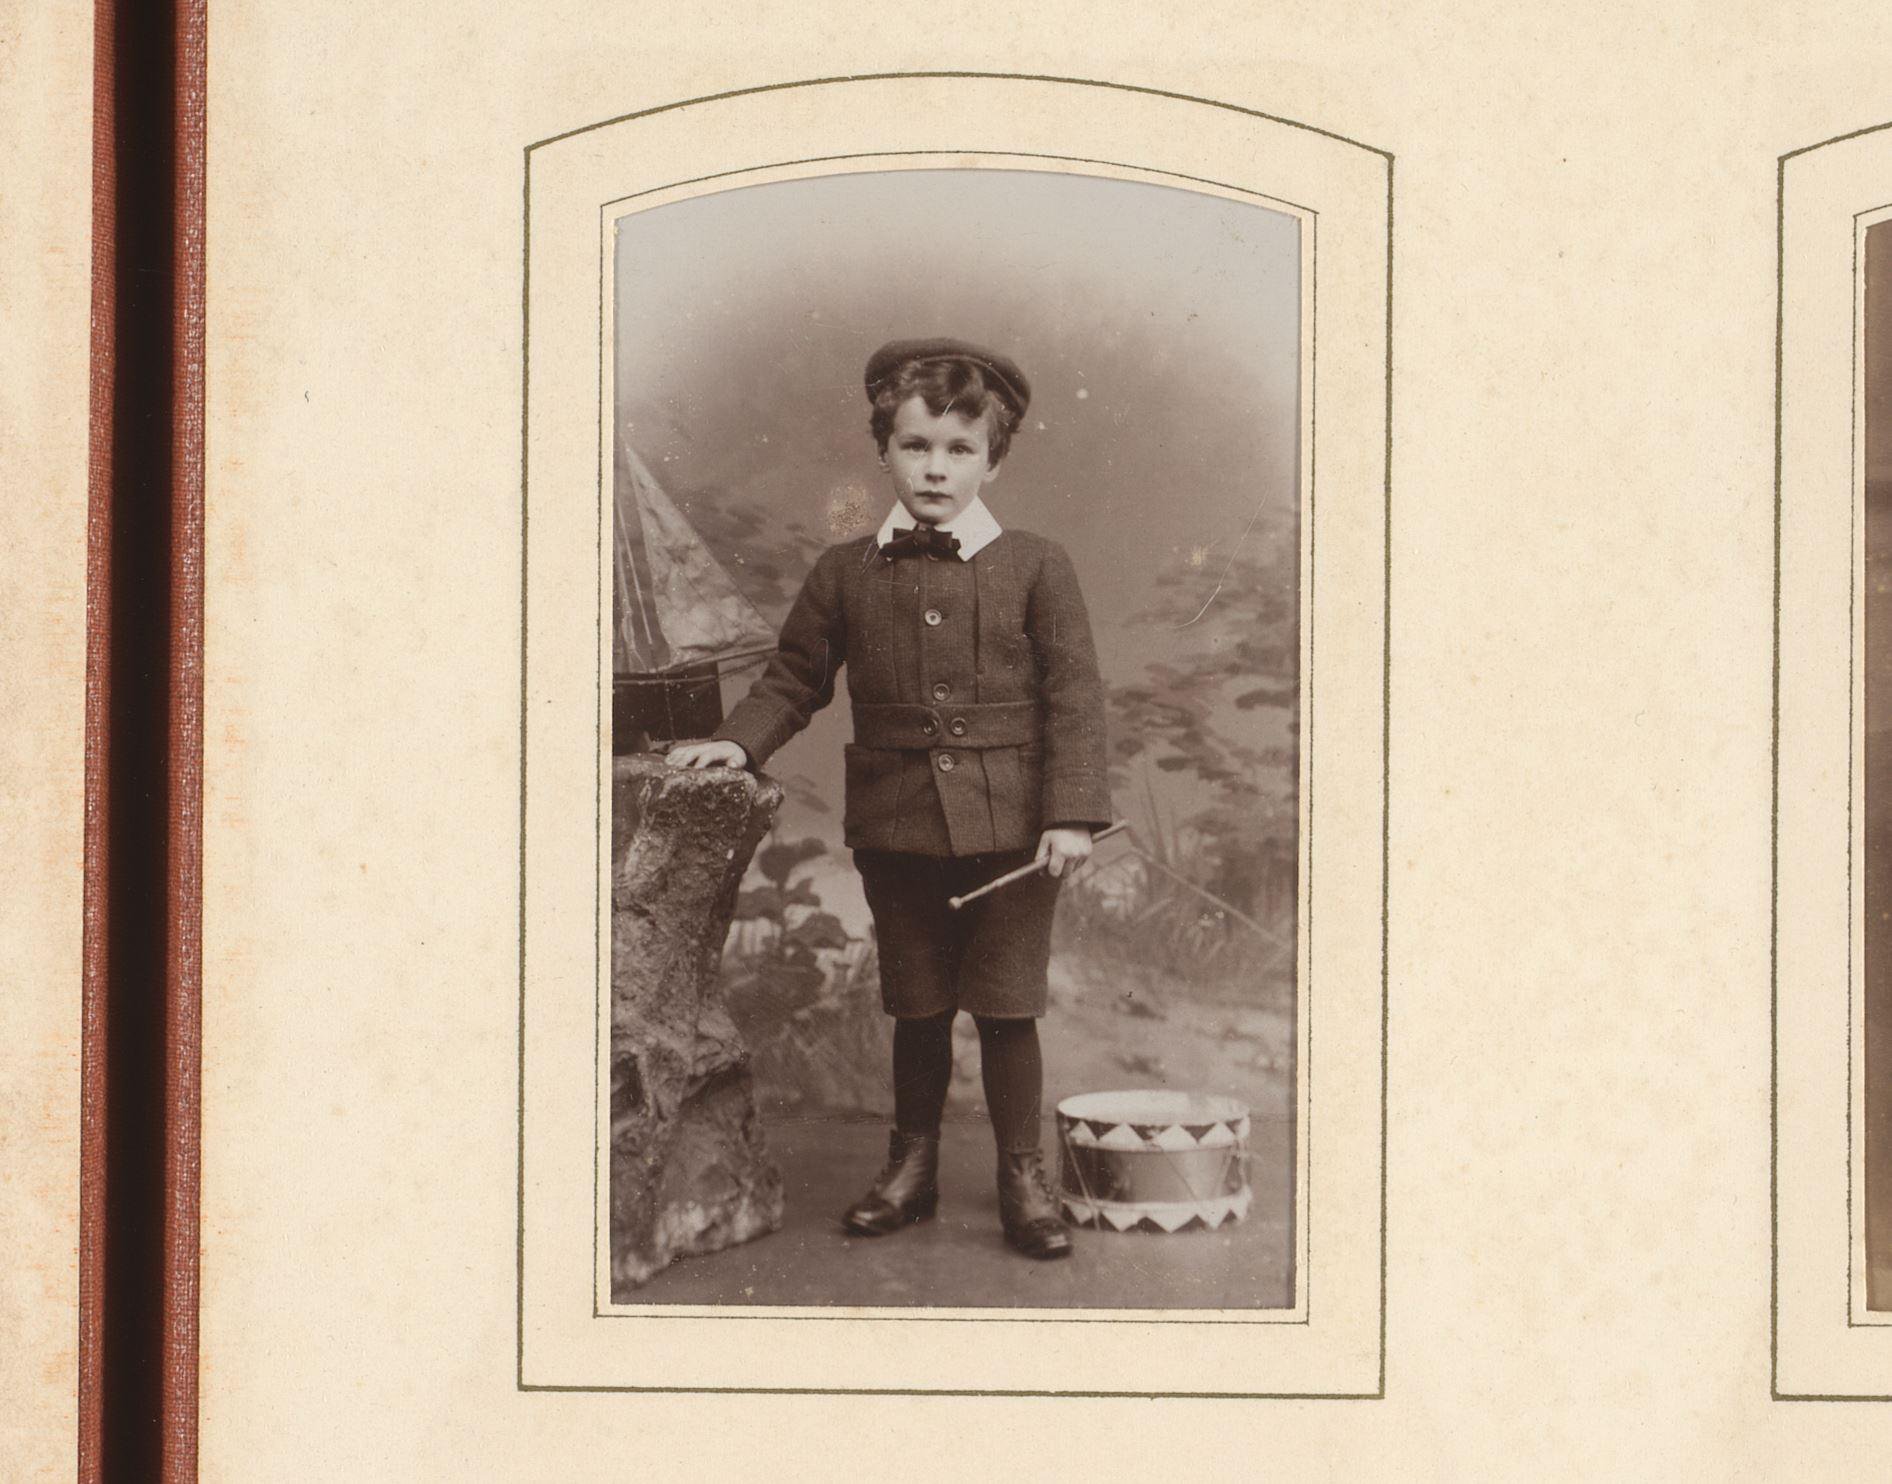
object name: album leaf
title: Portret van een jongen met trommel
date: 1890-1904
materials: cardboard, photographic support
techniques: collodion silver print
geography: utrecht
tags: boy (child between toddler and youth), historical persons, drum (musical instrument)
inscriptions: inscription: ‘Lietze & Schumaker/ Senatus Veteranorum Imaginum Luce Expressores/ Phot. Ateliers: van Wijckskade, No 22./ hoek Noorderstraat, Utrecht./ De platen blijven voor nabestelling bewaard.’